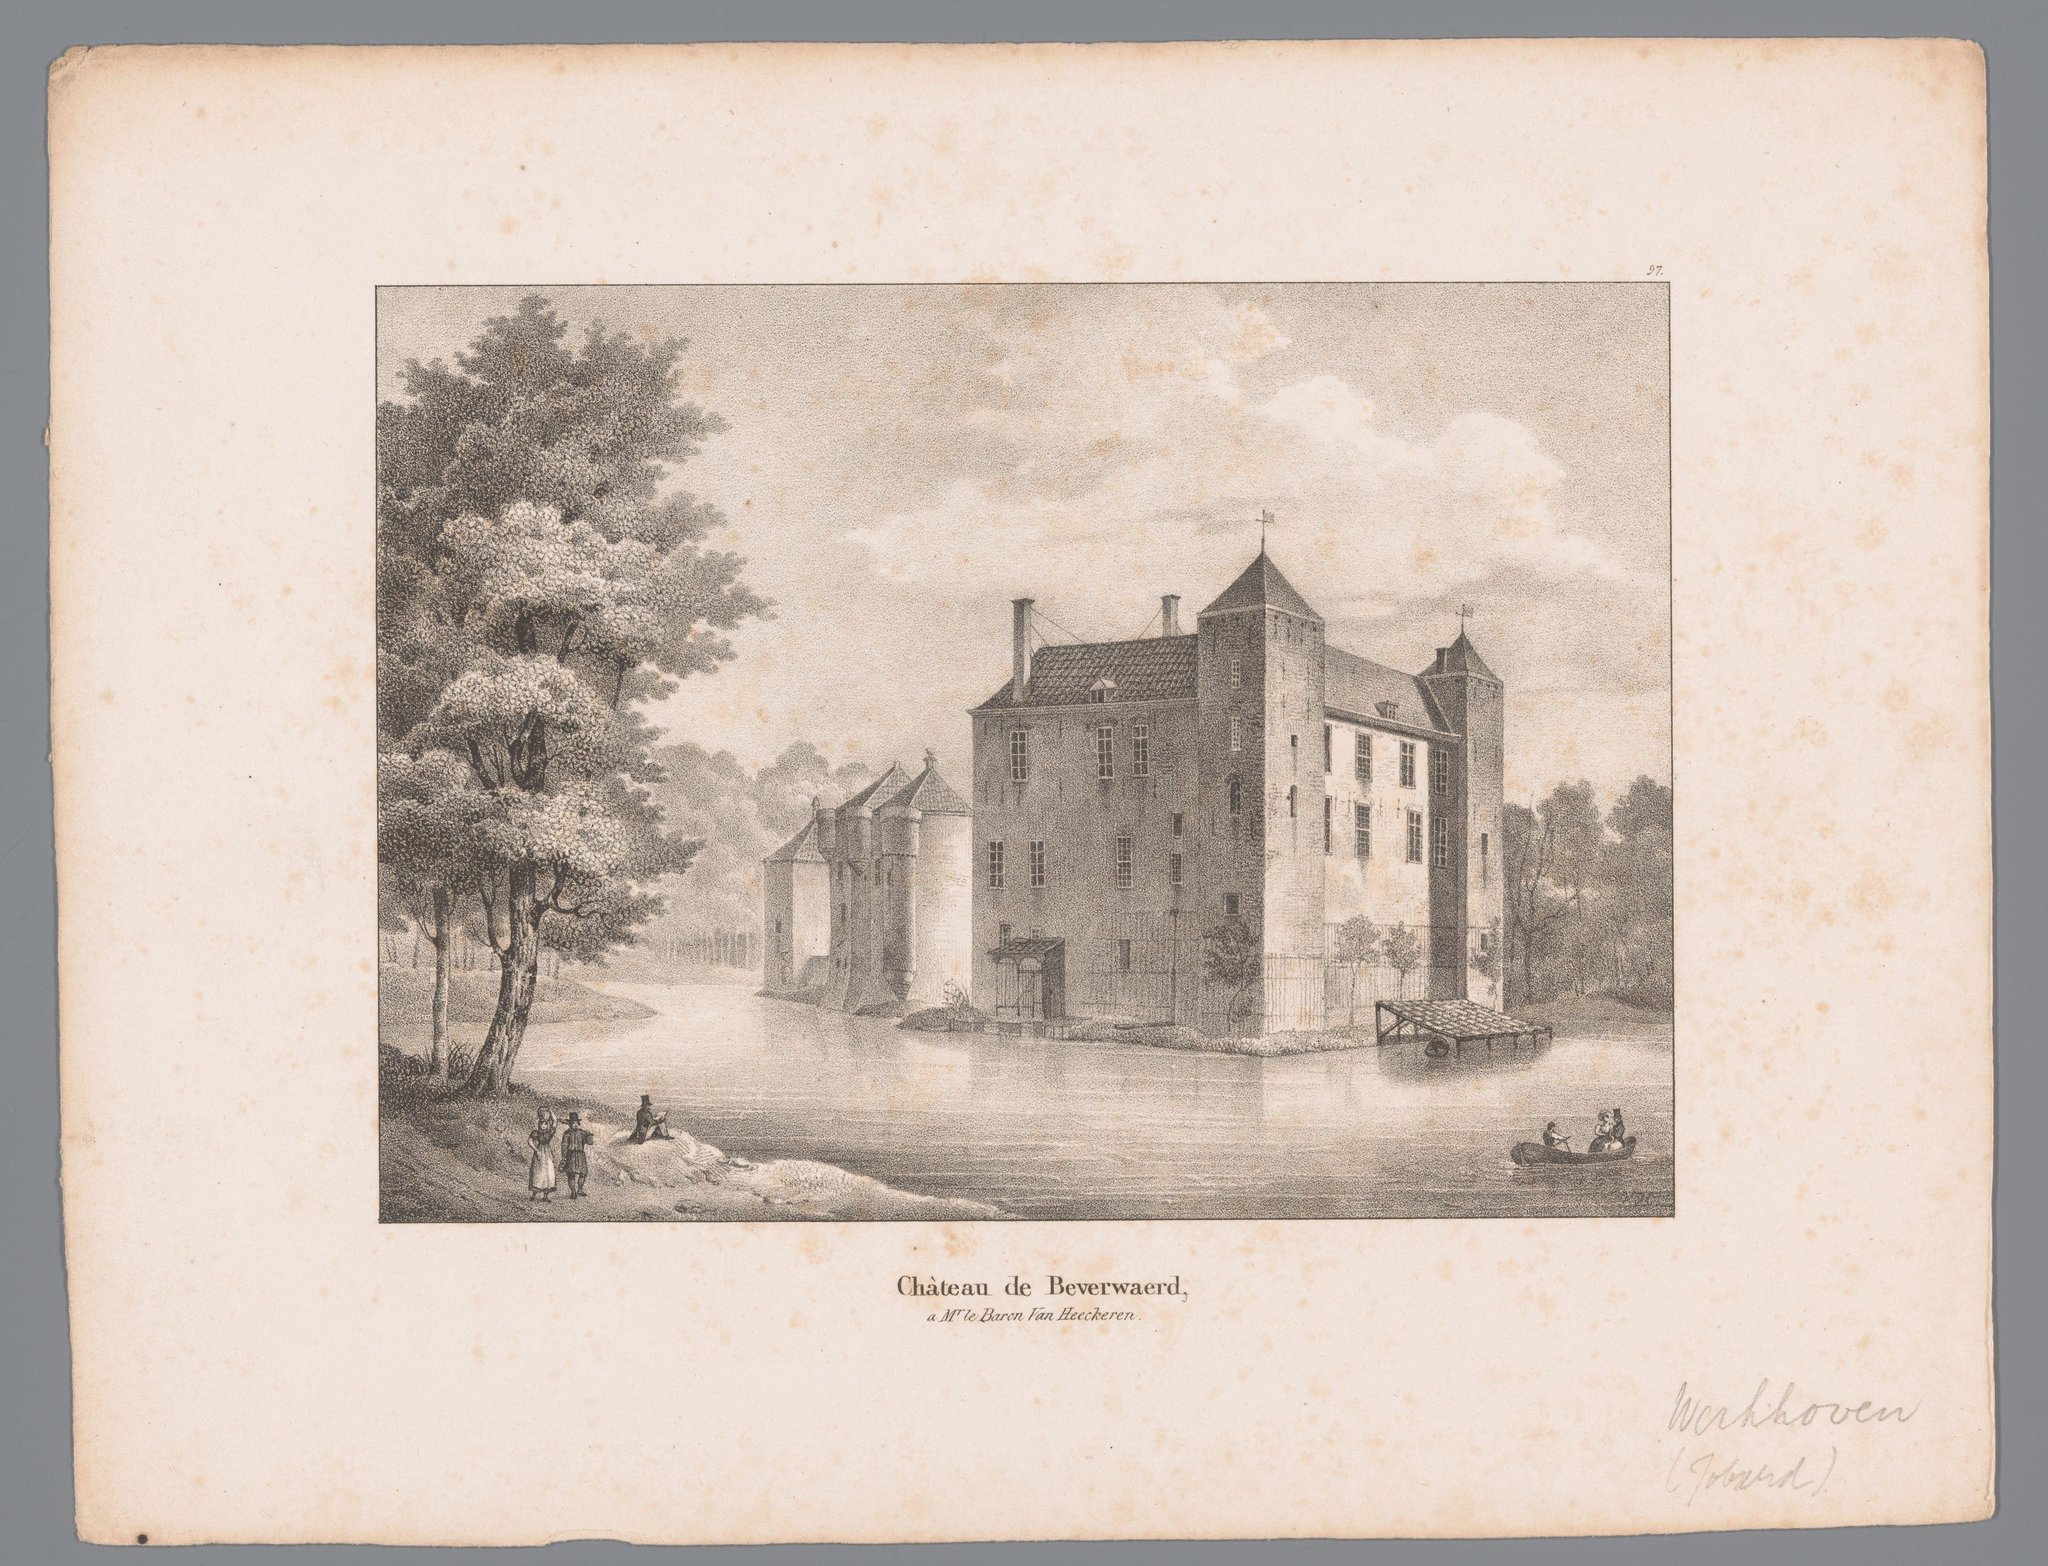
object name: print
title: Gezicht op kasteel Beverweerd bij Werkhoven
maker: Anonymous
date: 1827-1829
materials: paper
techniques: lithograph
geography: paris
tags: castle, landscape with tower or castle, kasteel beverweerd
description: Prent uit: Cloet, J.J. de. Châteaux et monumens des Pays-Bas (...). Parijs: Jobard Frères, [1827-1829], dl. ?, pl. 97.